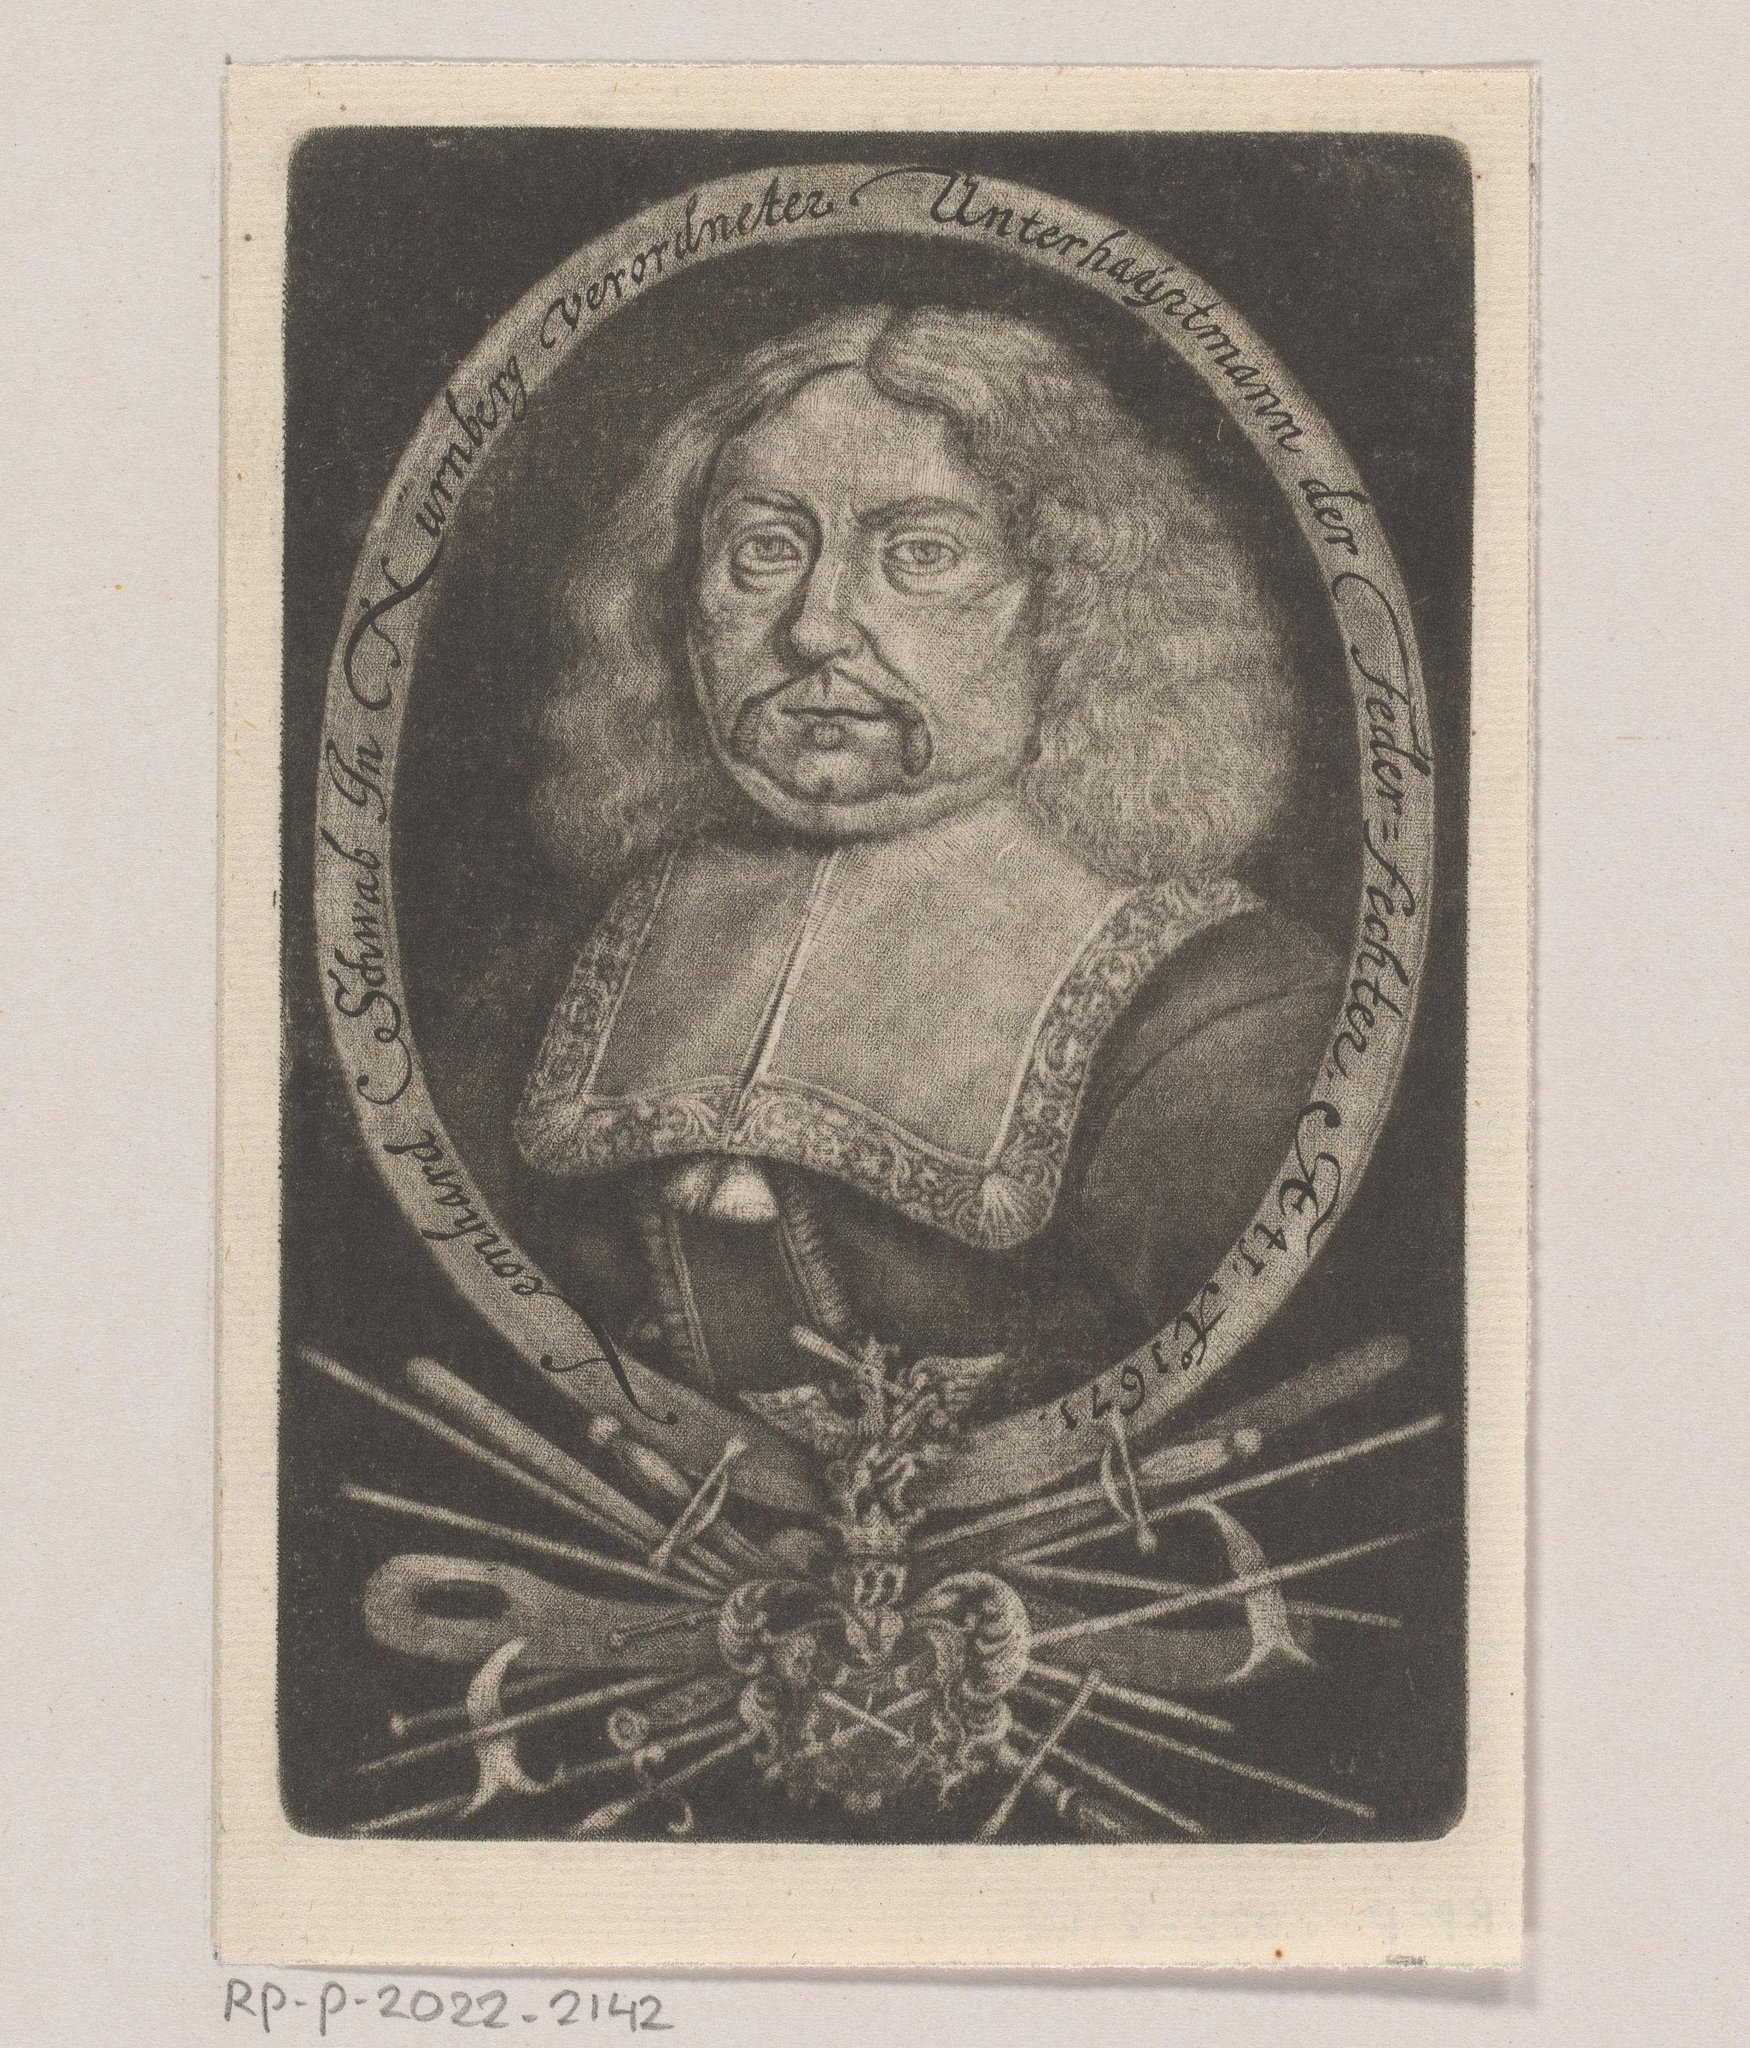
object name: print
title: Portret van Leonhard Schwab op 41-jarige leeftijd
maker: Anonymous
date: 1671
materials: paper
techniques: mezzotint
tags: historical persons, armorial bearing, heraldry, (military) equipment and supply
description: Met tekst in het Duits rondom het portret.